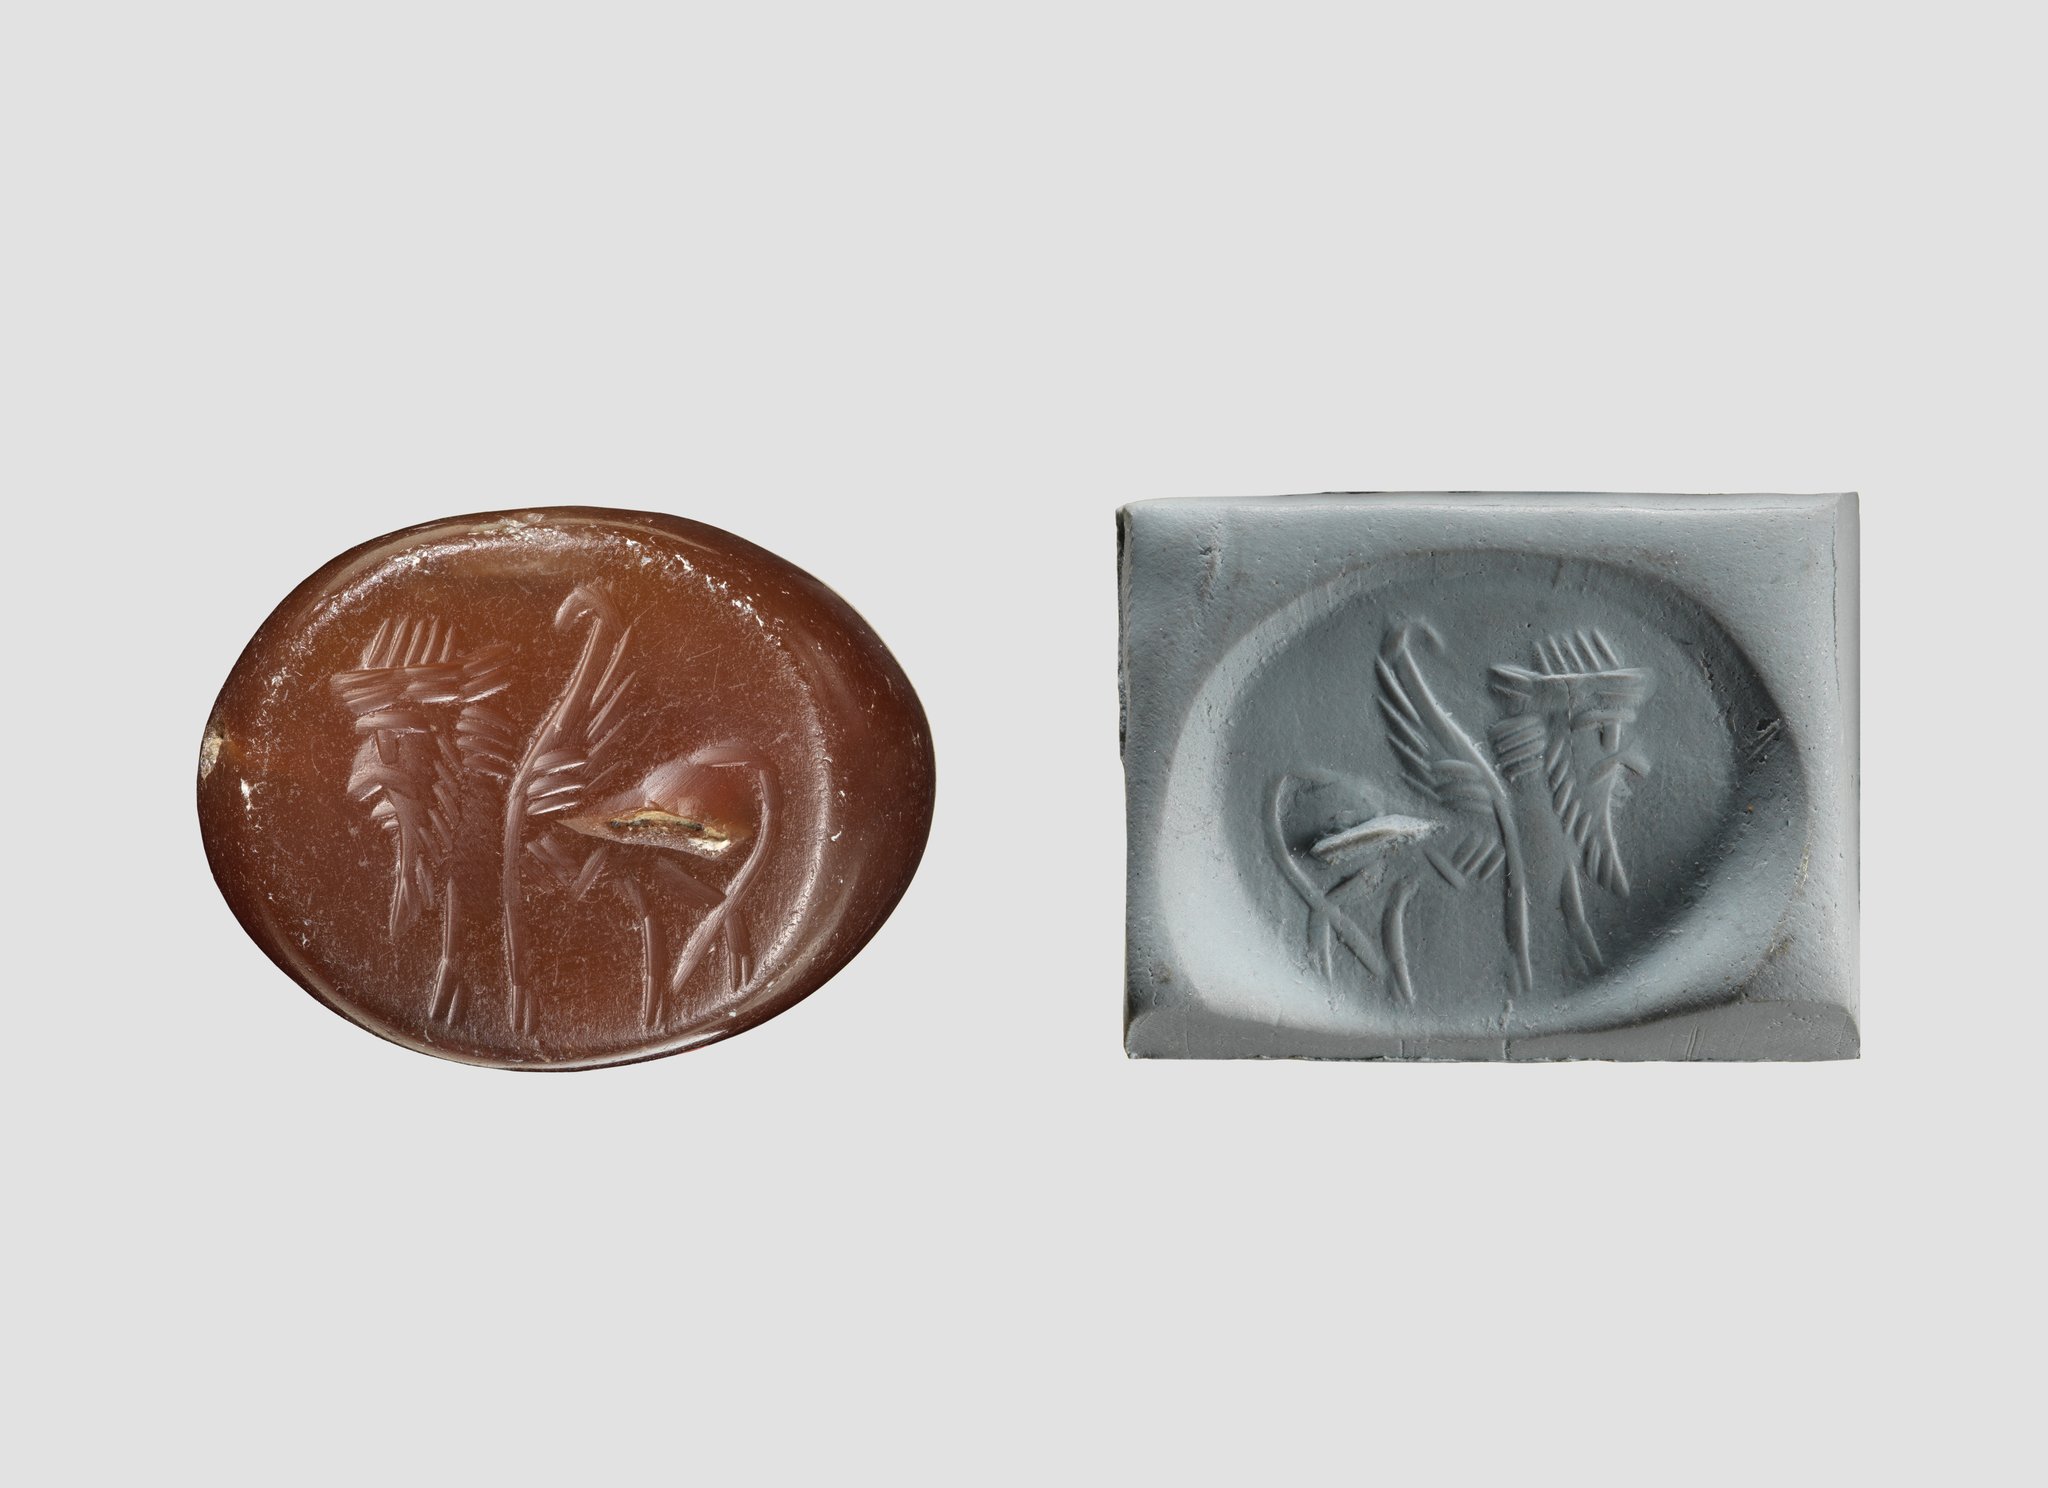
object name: stamp seal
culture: sasanian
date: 201-700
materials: stone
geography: iran or mesopotamia